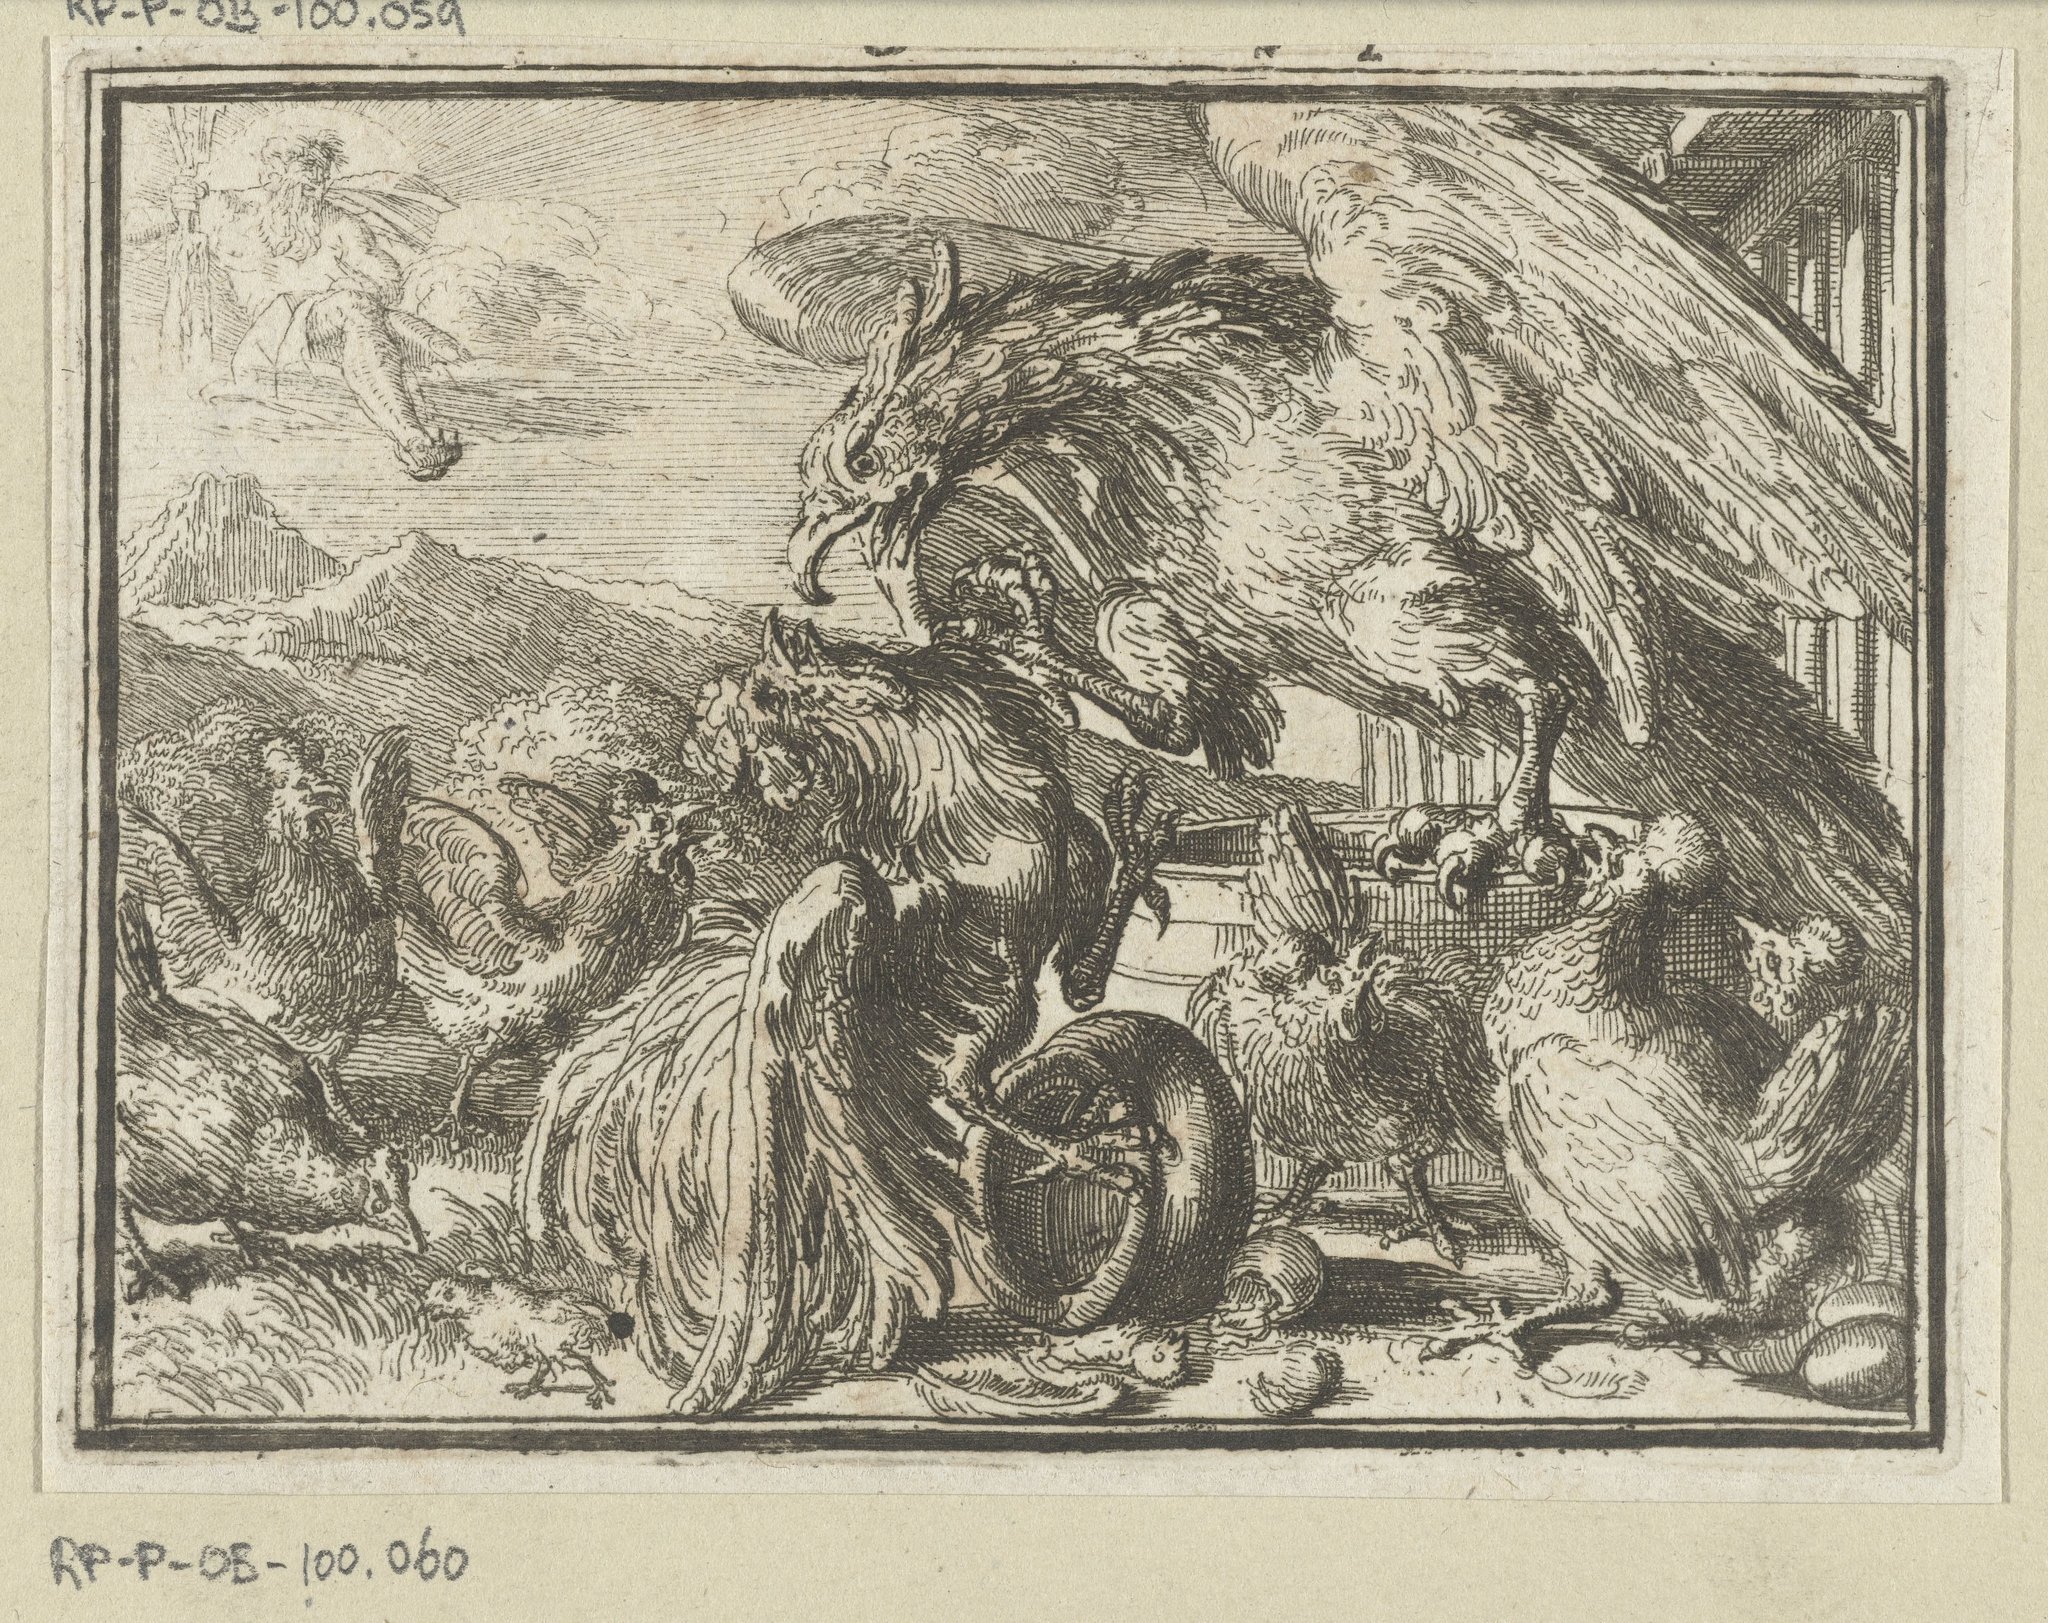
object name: print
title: Esopus in Europa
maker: romeyn de hooghe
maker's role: draughtsman, goldsmith, painter, print maker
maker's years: 1645-1708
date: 1701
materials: paper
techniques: etching, letterpress printing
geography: netherlands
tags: lombardije, spaanse successieoorlog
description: Op verzoek van de hennen (Lombardije) stuurt Jupiter een arend om de haan (Frankrijk) aan te vallen. Titel staat op apart tekstblad.